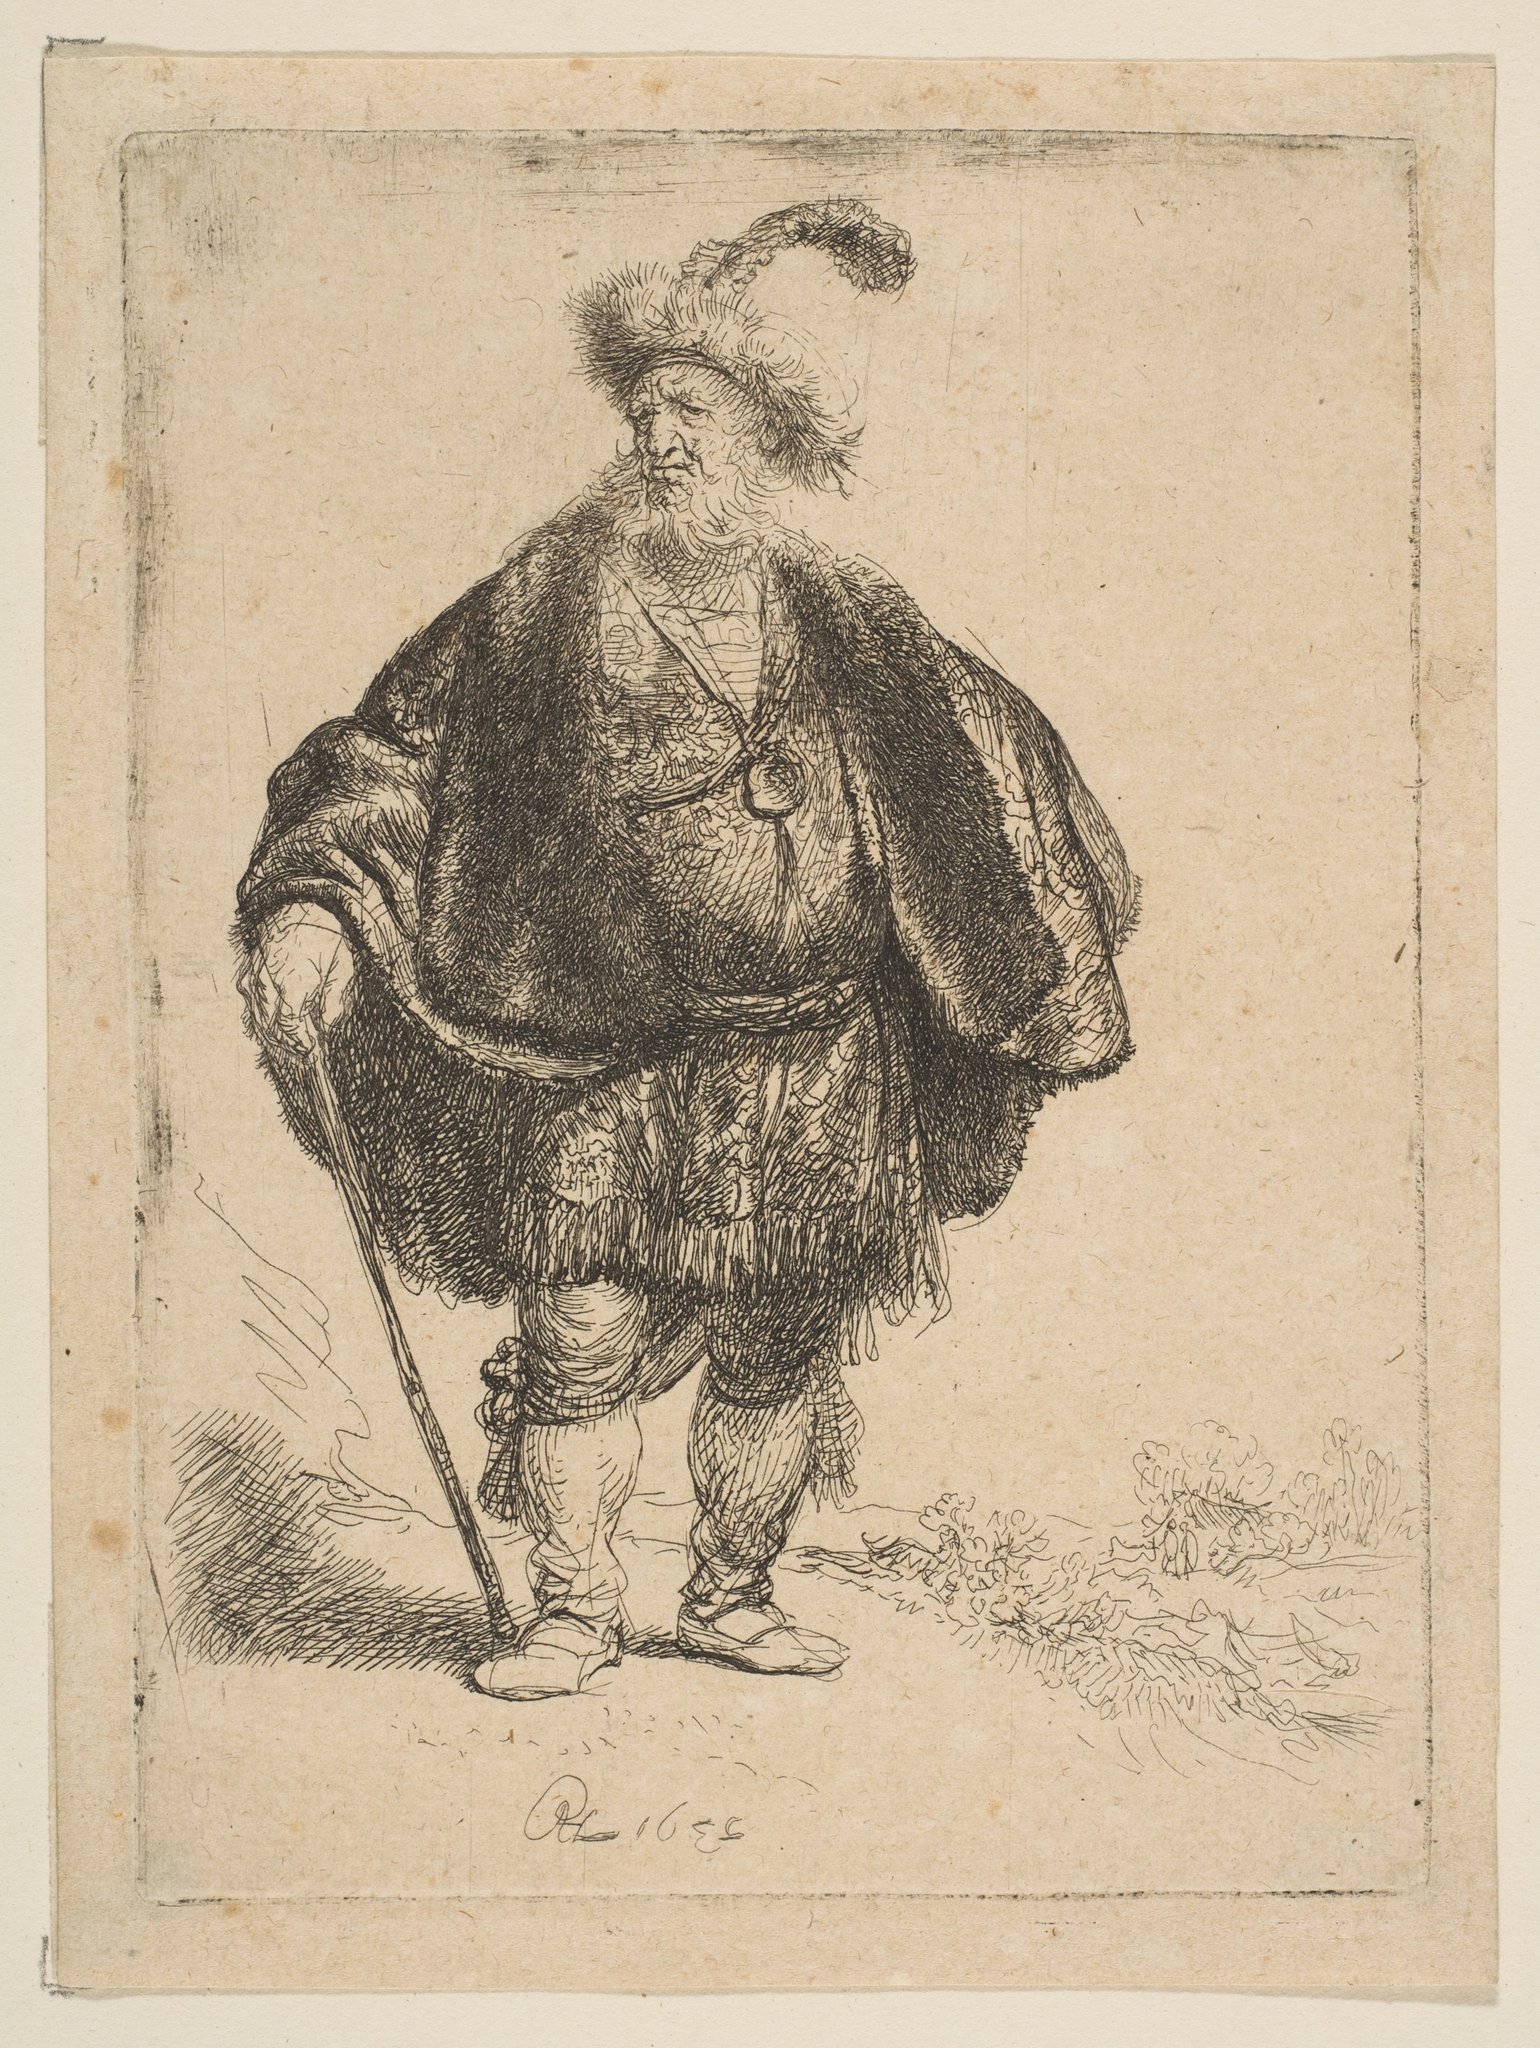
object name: print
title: The Persian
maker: rembrandt van rijn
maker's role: artist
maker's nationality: dutch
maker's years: 1606-1669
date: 1632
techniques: etching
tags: men